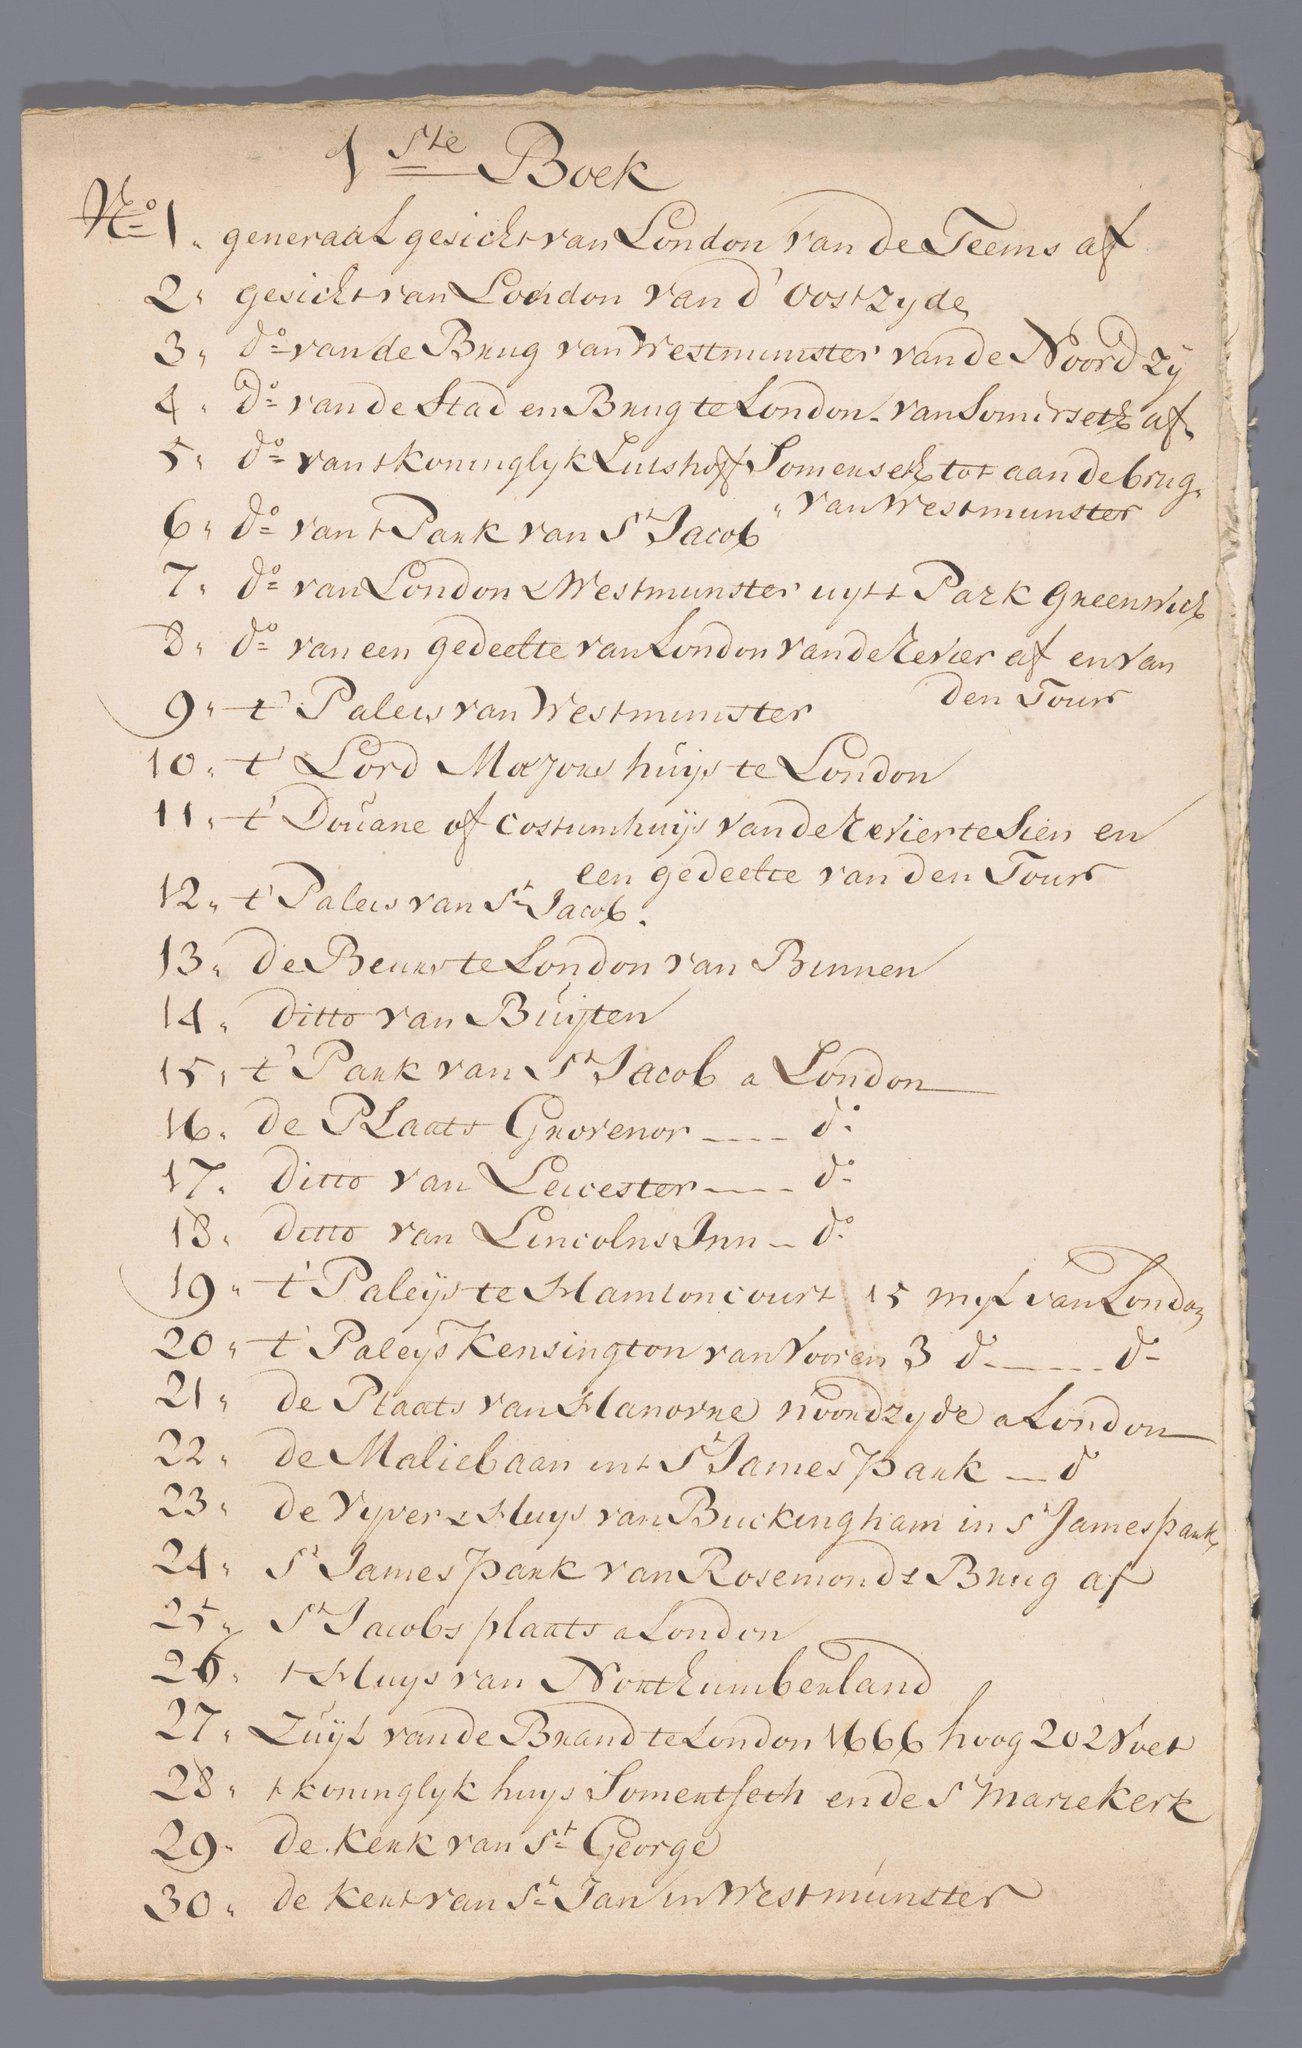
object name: document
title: Lijst met opticaprenten van de familie Six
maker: Anonymous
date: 1750-1799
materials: ink, paper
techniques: pen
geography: netherlands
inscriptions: annotation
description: Vier bladen met genummerde titels van opticaprenten.